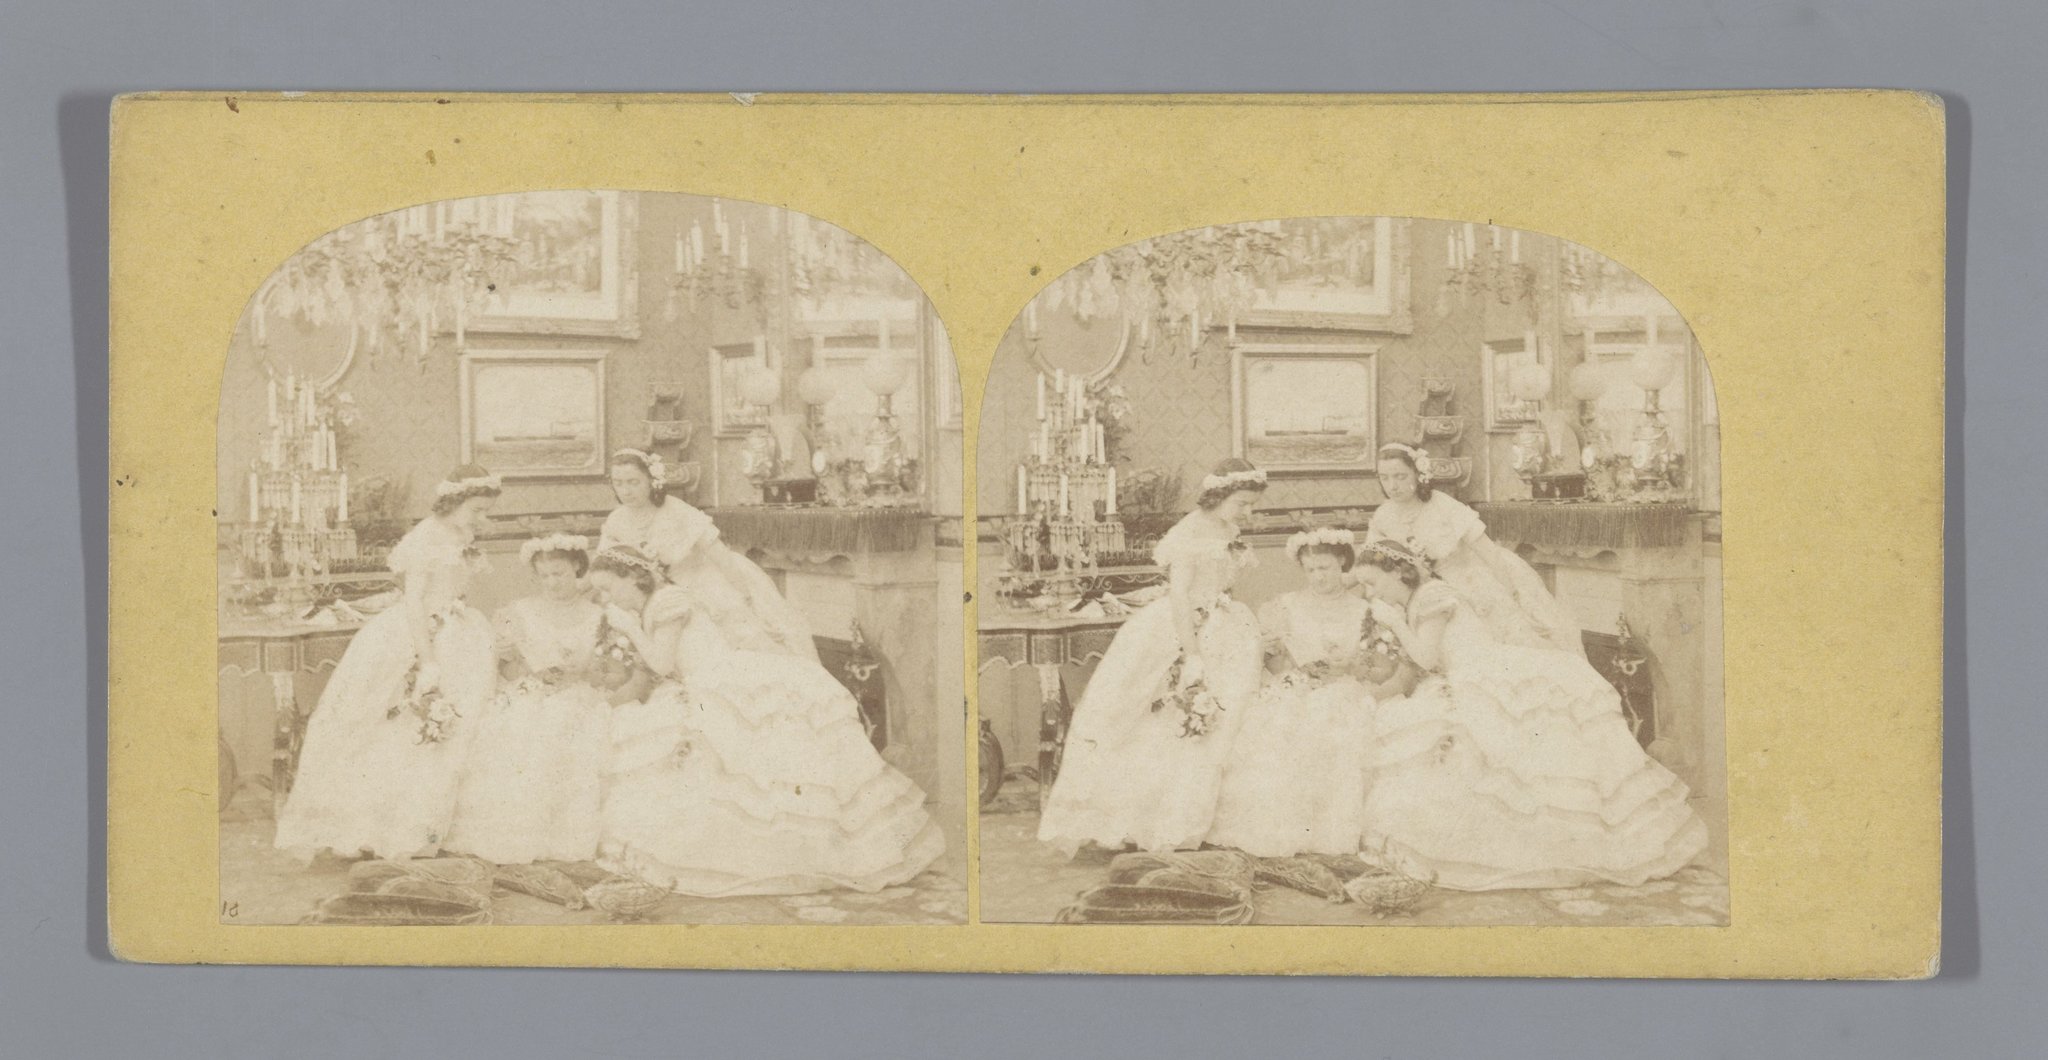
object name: stereograph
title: Vier bruidsmeisjes in een kamer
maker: Anonymous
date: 1850-1880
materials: cardboard, photographic support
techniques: albumen print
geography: europe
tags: bridesmaid, europe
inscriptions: number: ‘10’